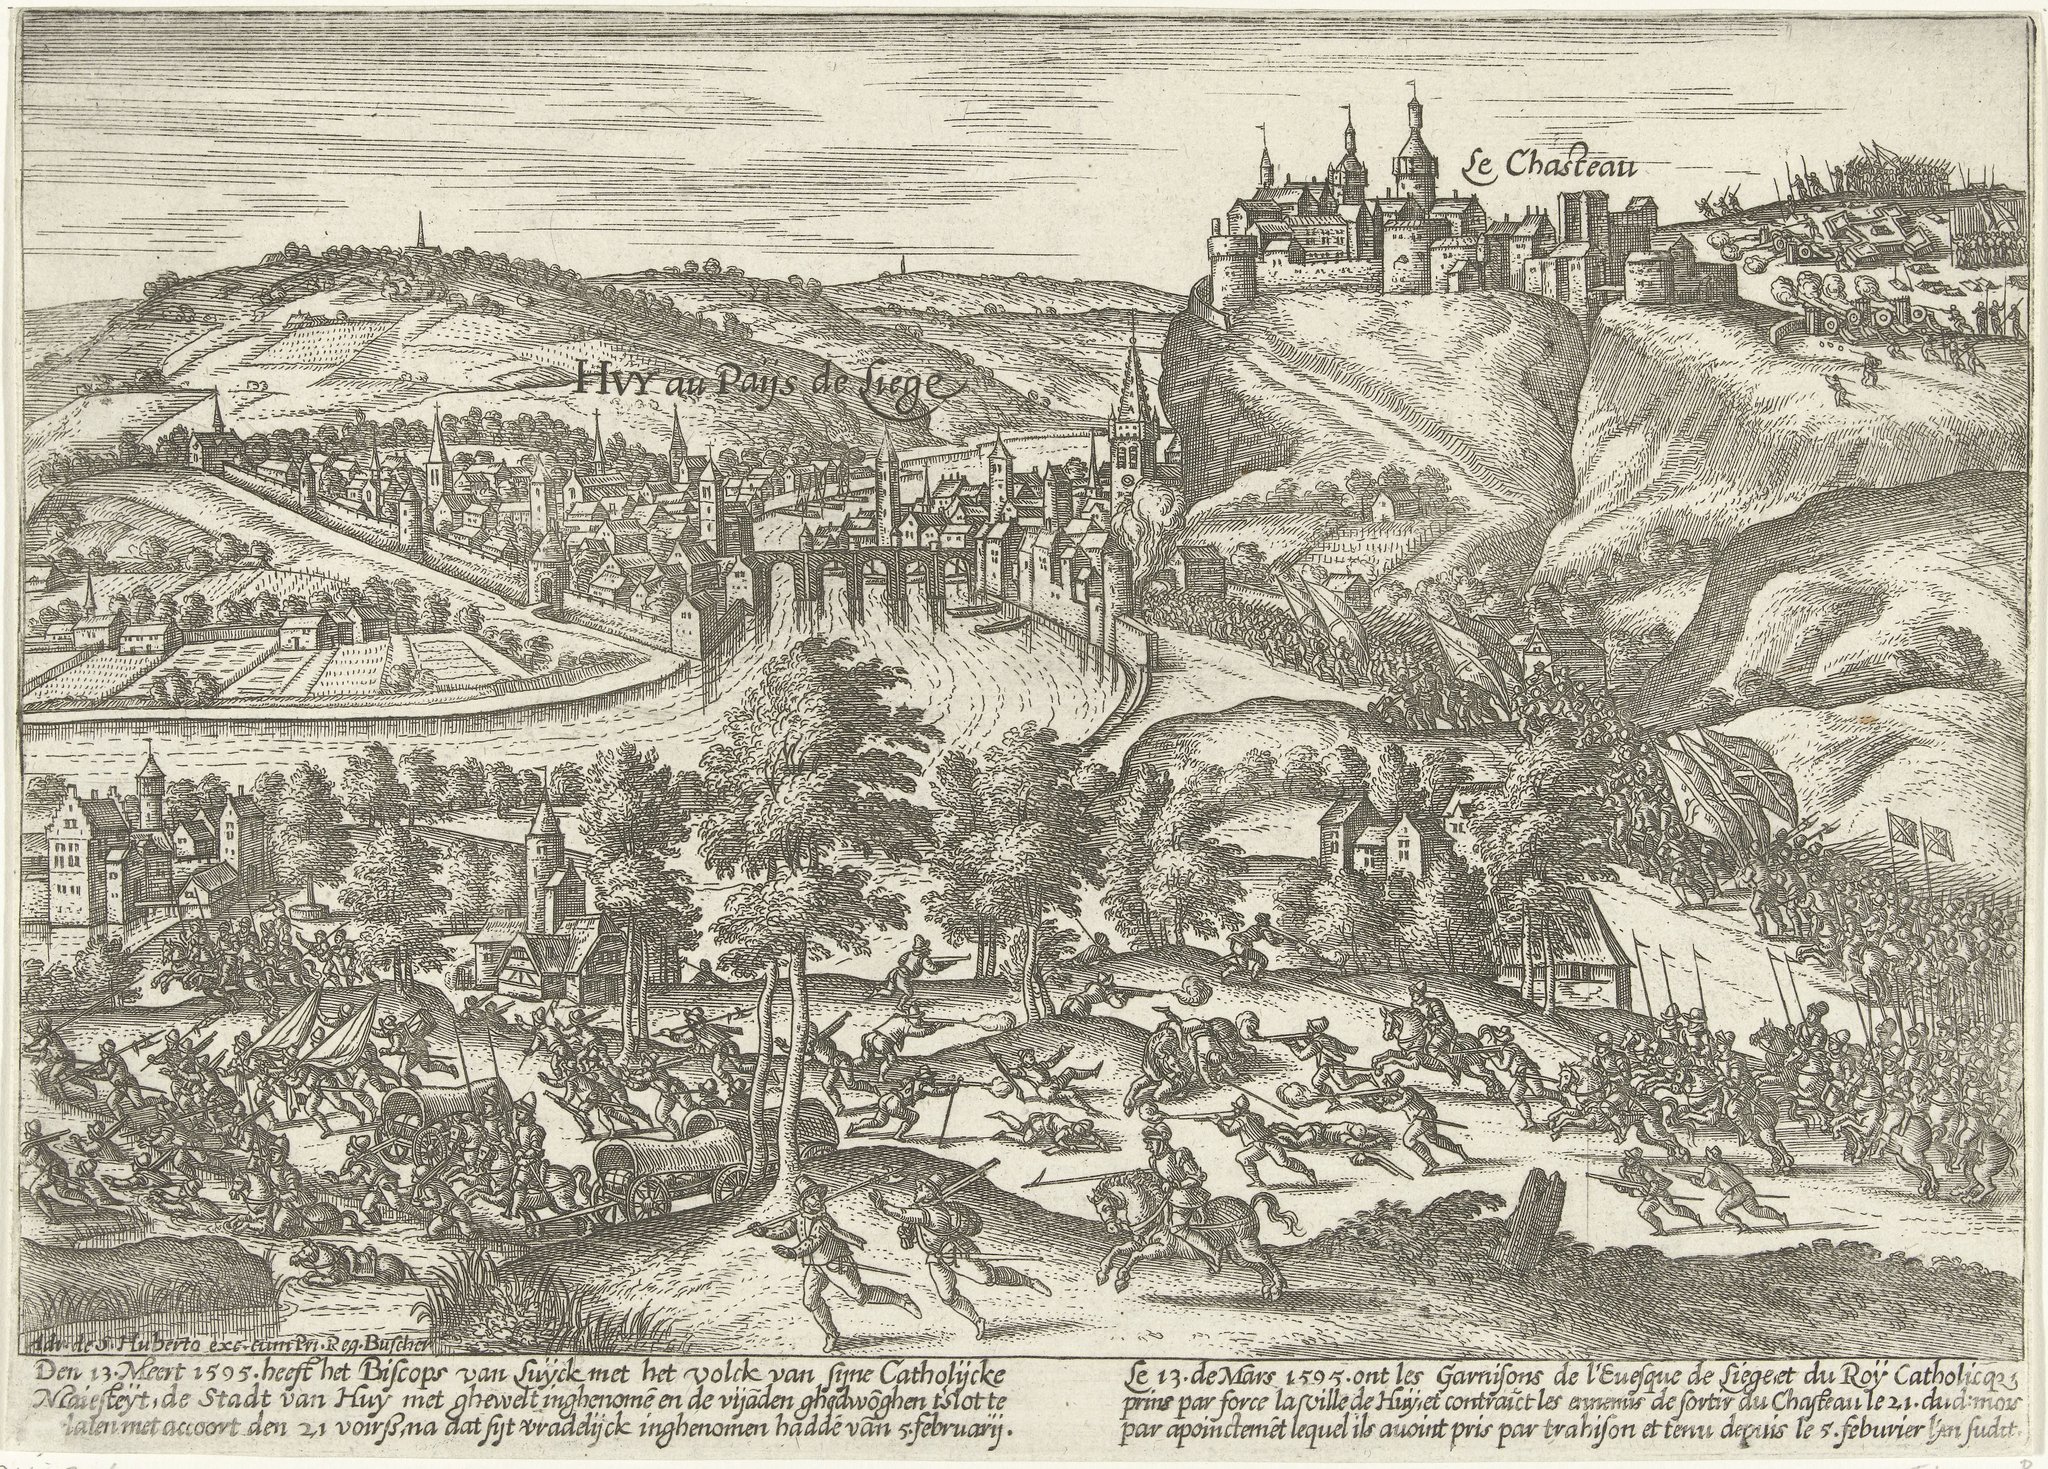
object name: print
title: Herovering van Hoei door de bisschop van Luik, 1595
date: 1595-1633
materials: paper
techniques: etching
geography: southern netherlands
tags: capture of city (after the siege)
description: Herovering van Hoei door de bisschop van Luik op het Staatse leger, 21 maart 1595. Gezicht op de stad en het kasteel met gevechten tussen beide legers op de voorgrond. Met onderschrift van 3 regels in het Nederlands en 3 regels in het Frans.